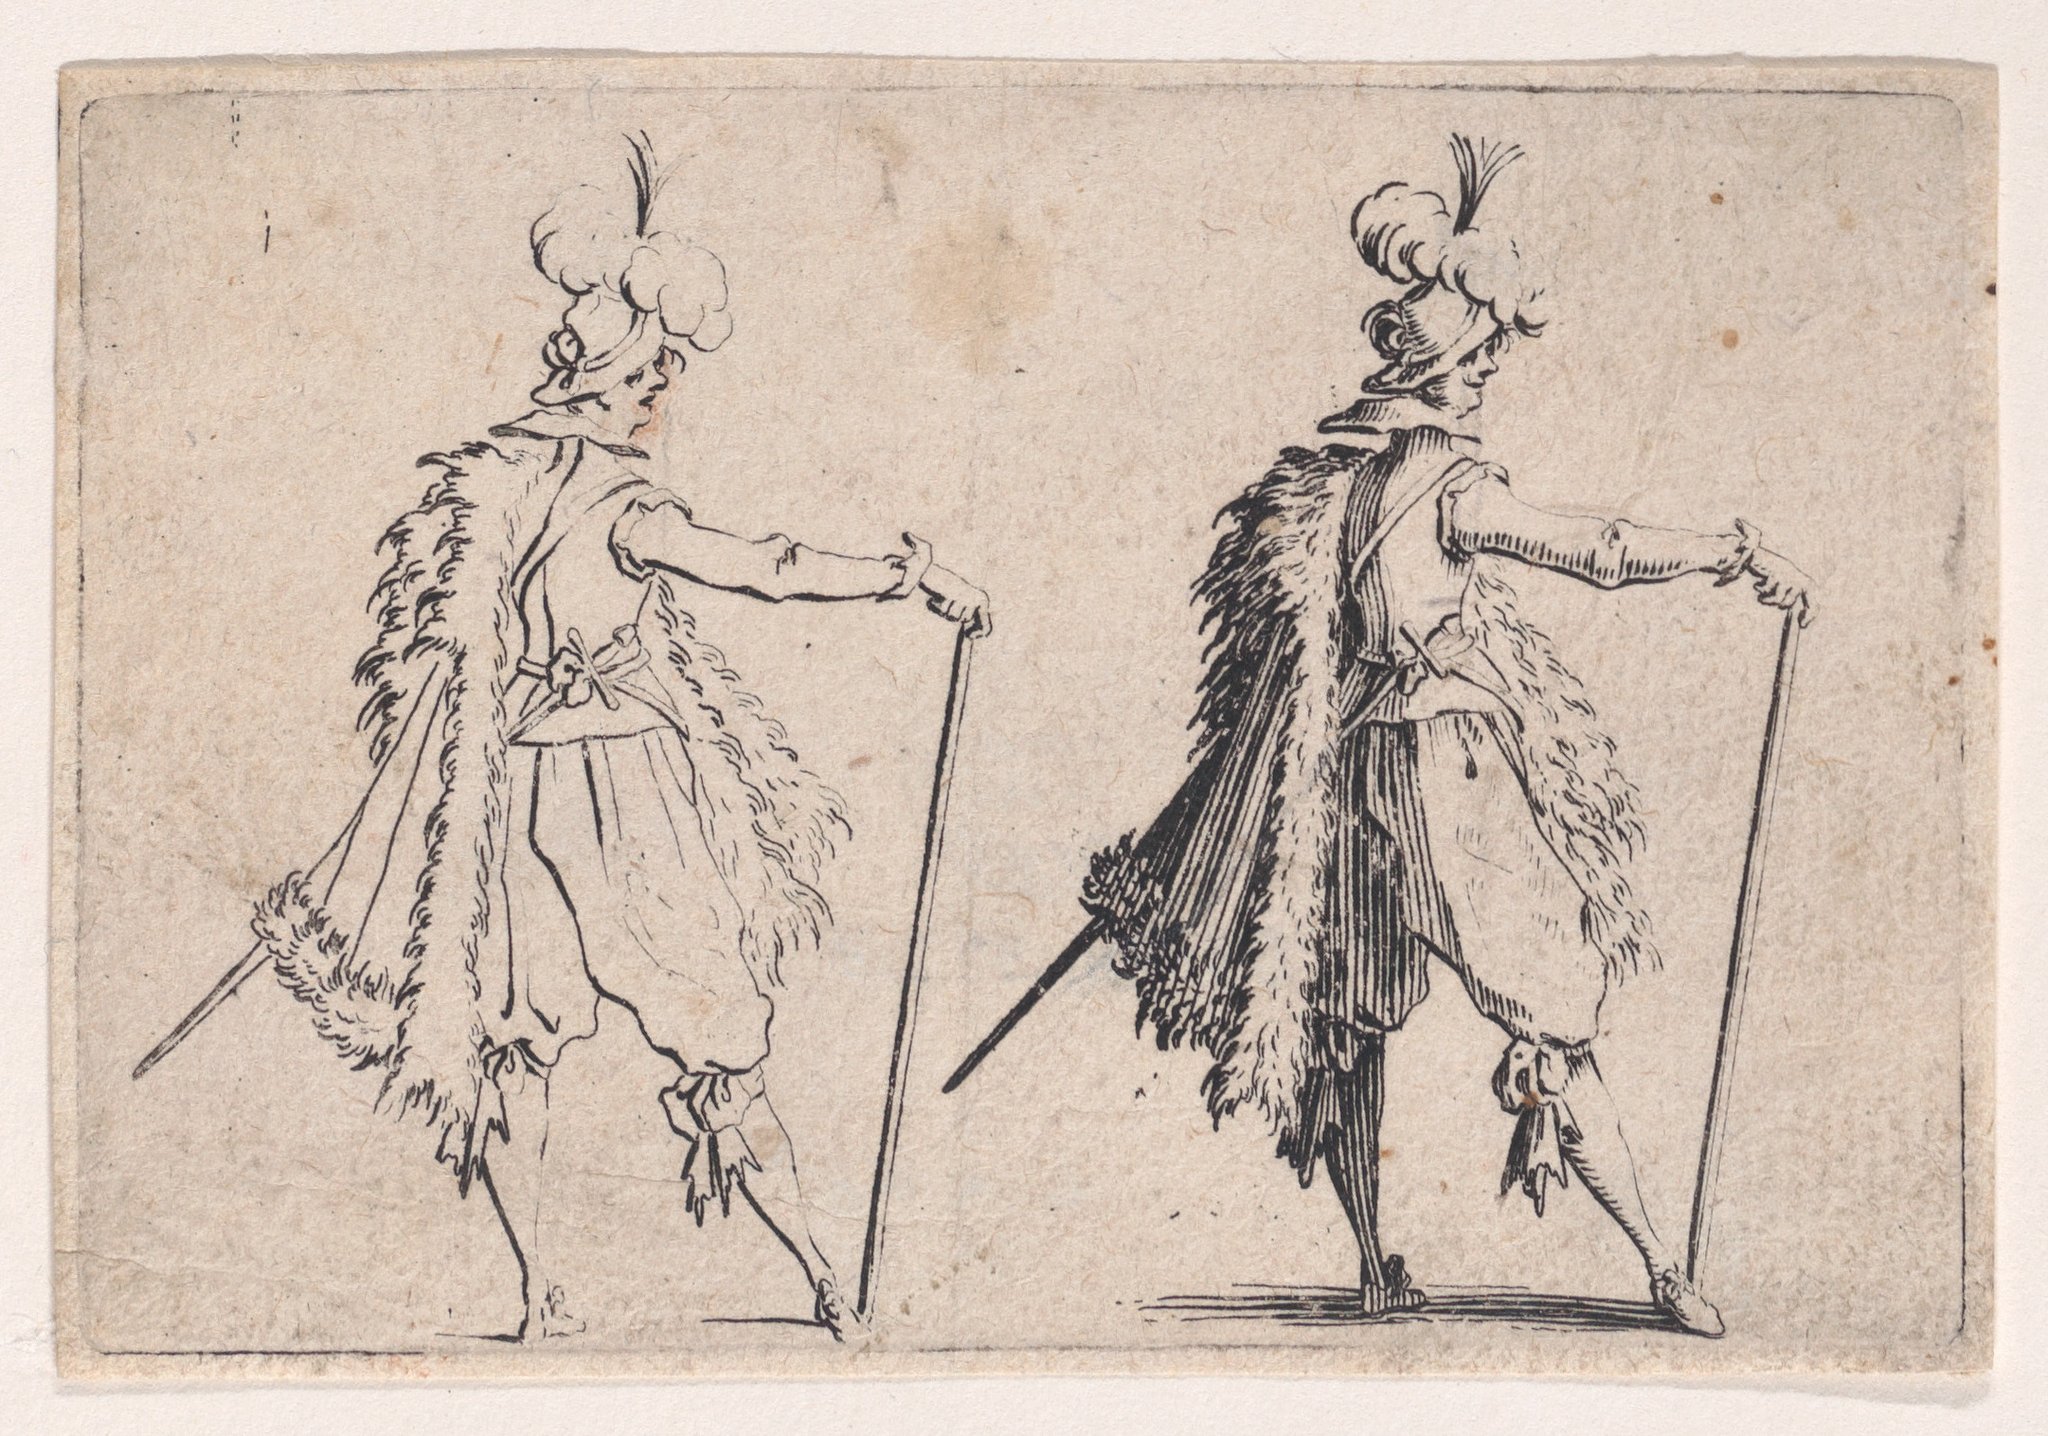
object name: print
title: Le Gentilhomme a la Grande Canne (The Gentleman with a Large Cane), from Les Caprices Series B, The Nancy Set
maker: jacques callot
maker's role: artist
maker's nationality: french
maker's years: 1592-1635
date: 1617-1620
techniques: etching